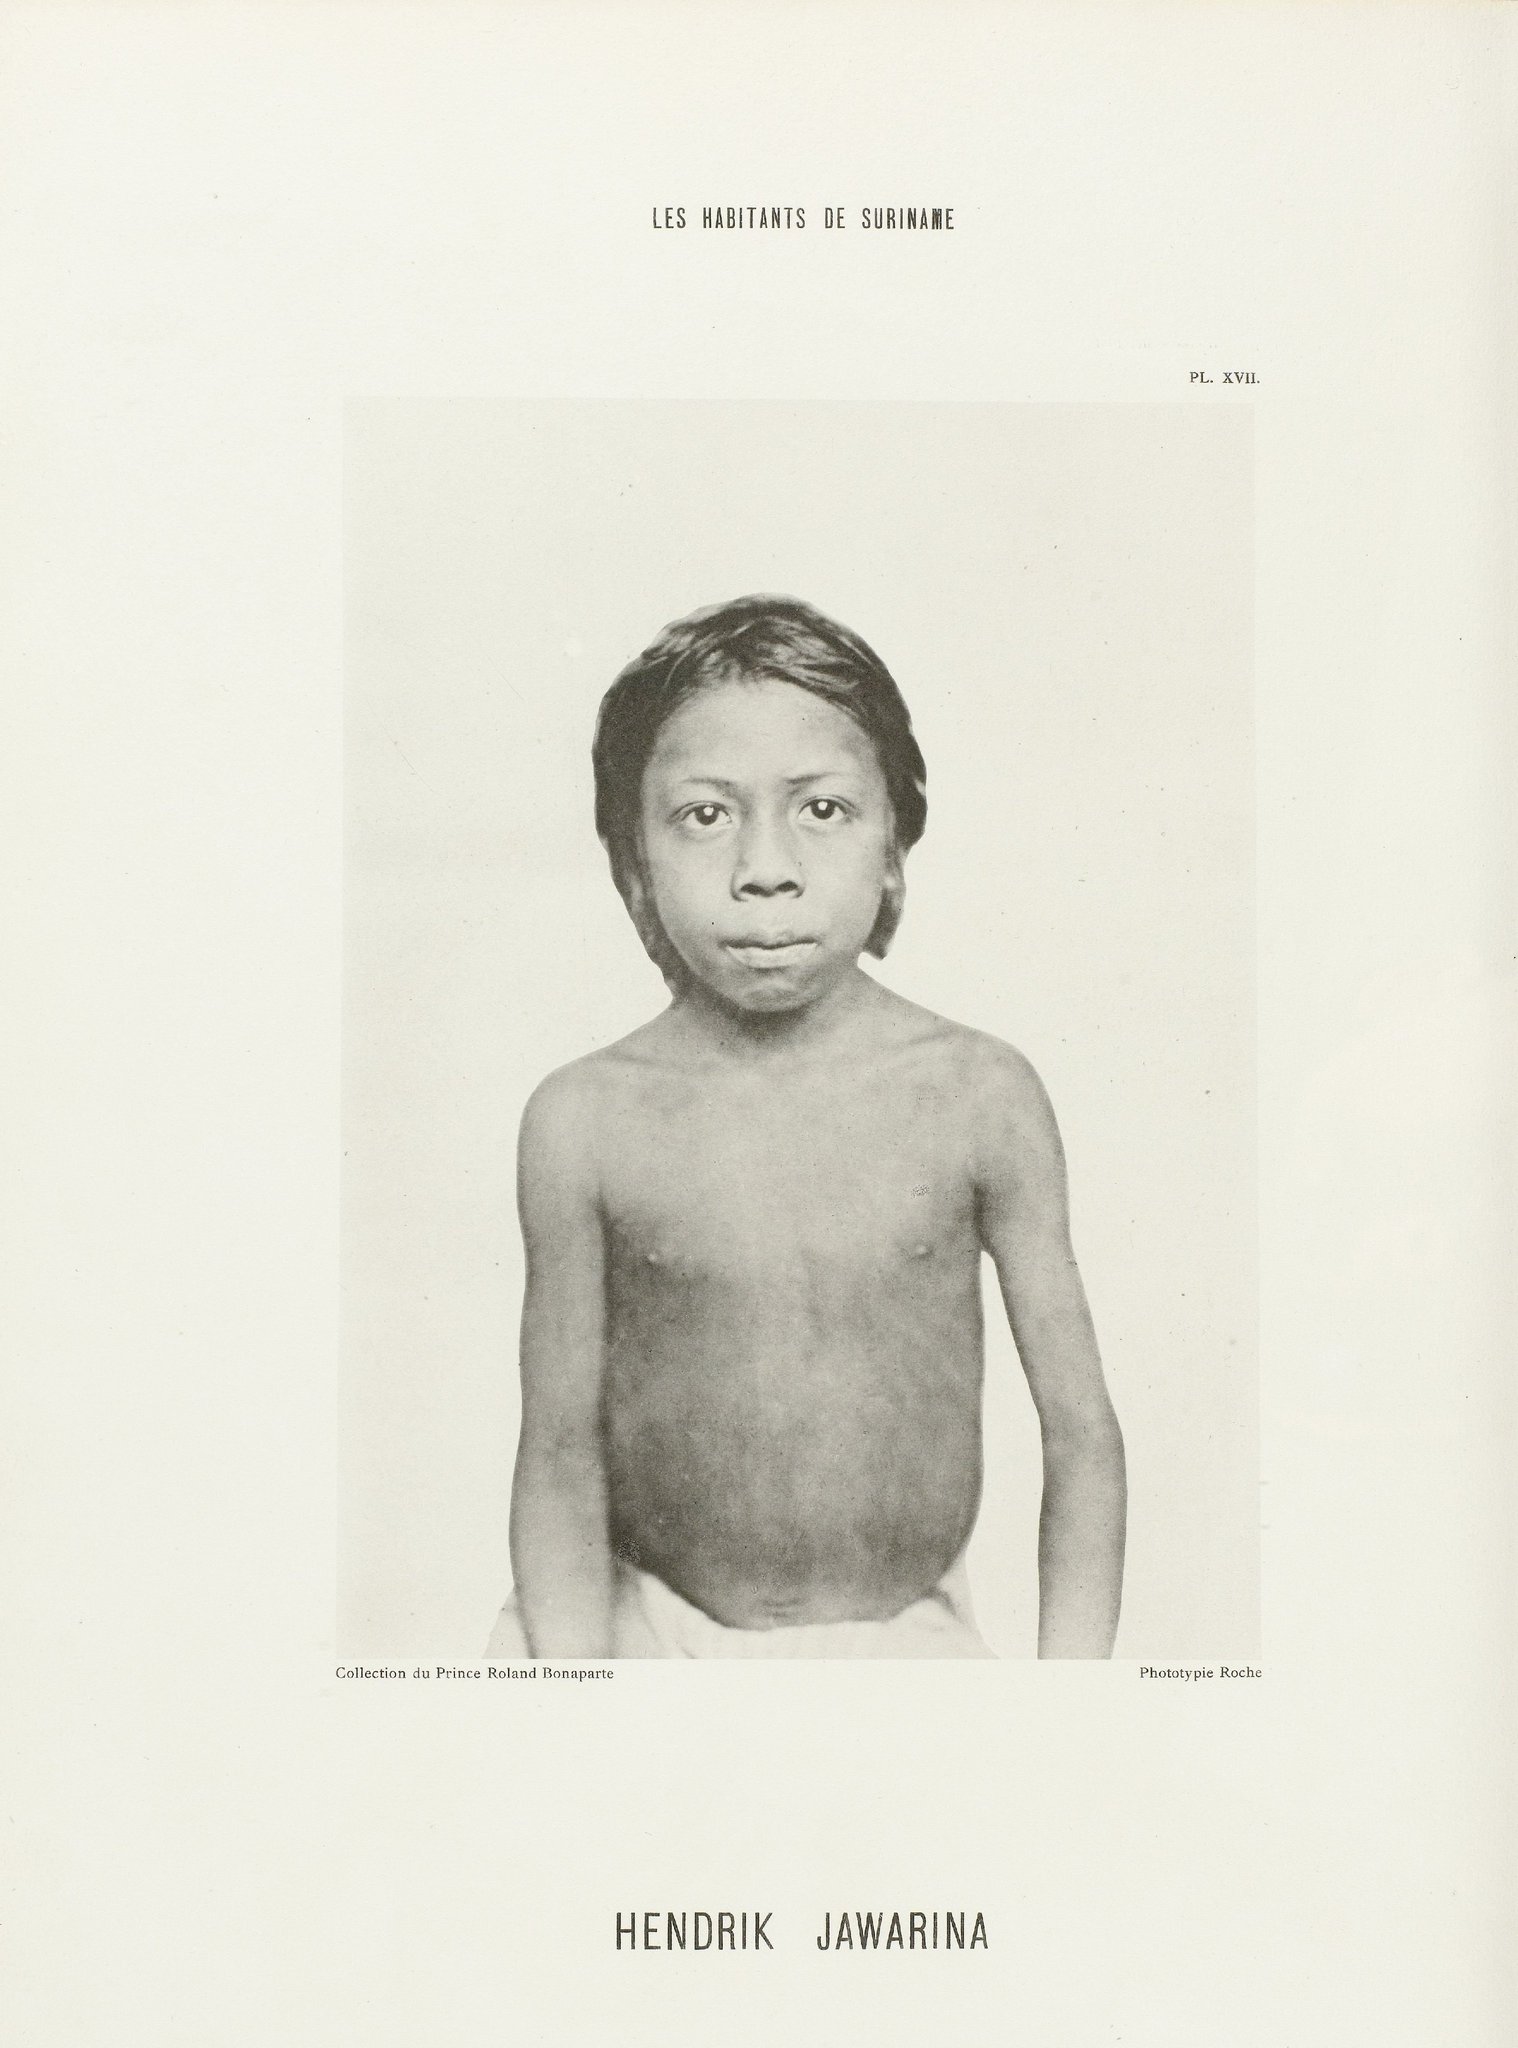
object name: photomechanical print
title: Portret van Hendrik Jawarina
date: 1883-1884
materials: paper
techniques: photograph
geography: amsterdam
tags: boy (child between toddler and youth), historical persons, indigenous peoples of south america, amsterdam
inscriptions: inscription: ‘Collection du Prince Roland Bonaparte/ Phototypie Roche’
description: Portret van Hendrik Jawarina, een Caraïb uit Suriname, gefotografeerd op de Internationale Koloniale en Uitvoerhandel Tentoonstelling, Amsterdam 1883.